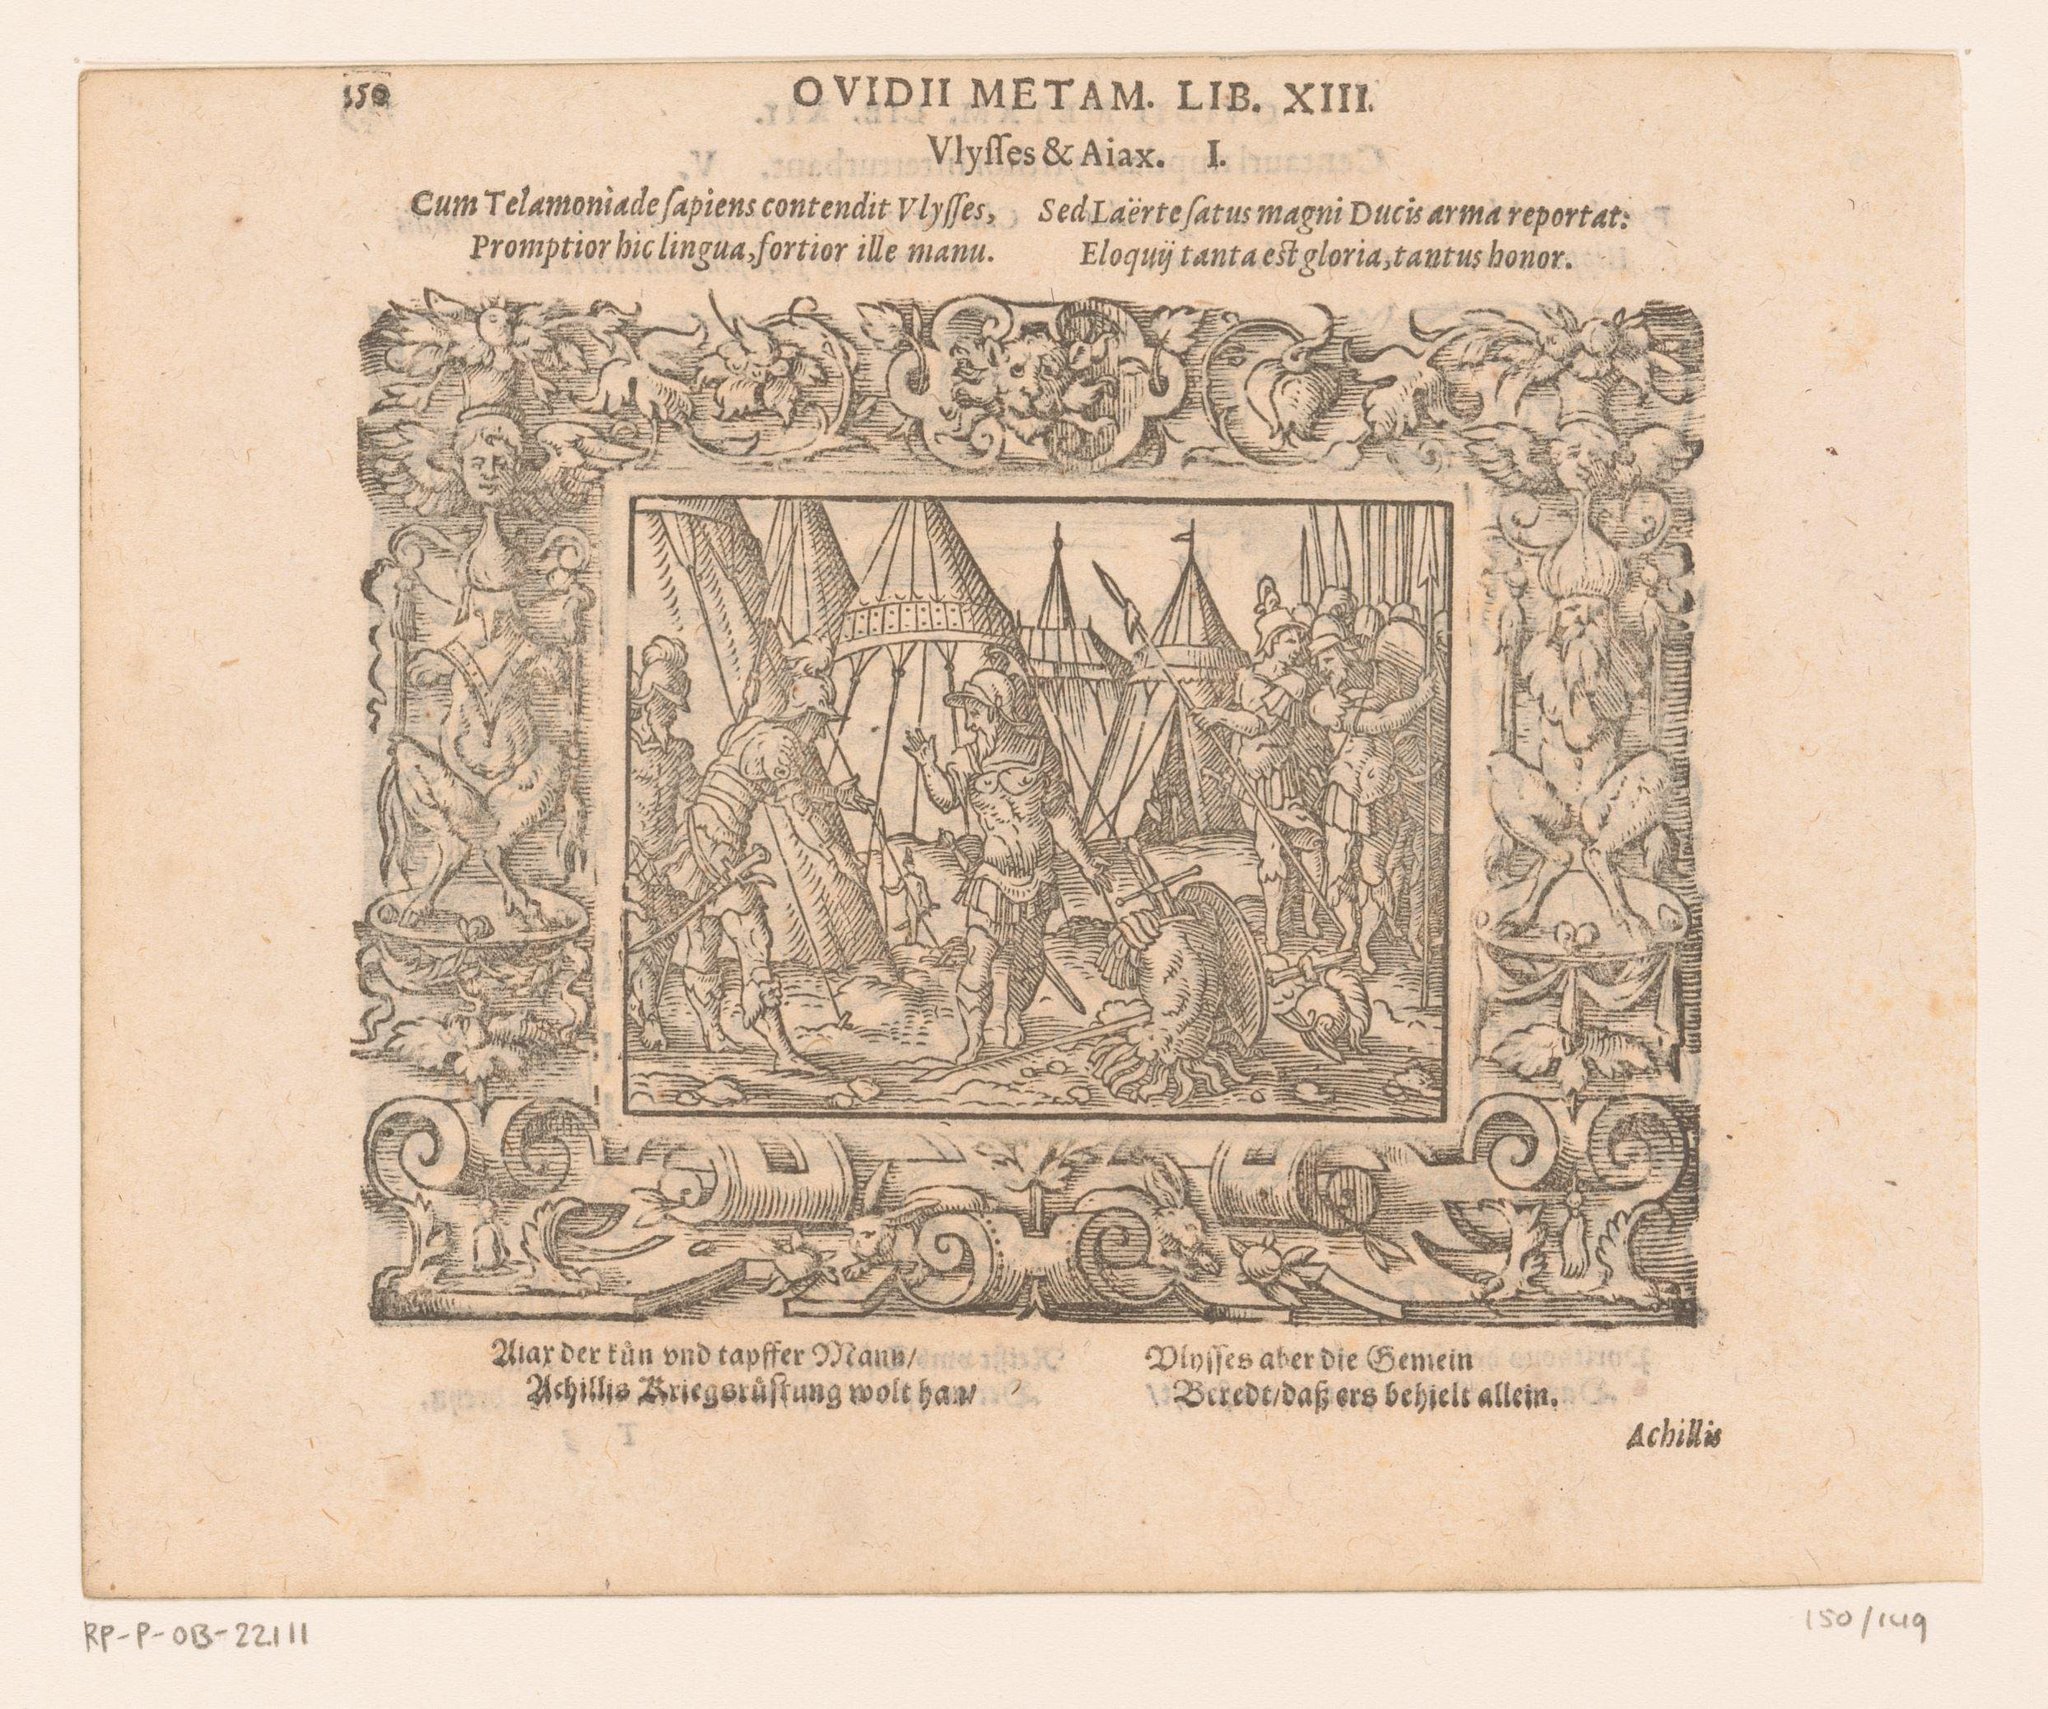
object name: book illustration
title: Ajax en Odysseus twisten om de wapens van Achilles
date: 1569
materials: paper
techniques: letterpress printing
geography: frankfurt am main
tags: fight between ulysses and ajax the great for achilles' arms, scrollwork, strapwork ~ ornament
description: Illustratie bij de Metamorfosen van Ovidius, afkomstig uit de publicatie: Posthius, Johannes. Tetrasticha in Ovidii metam. Frankfurt am Main: Georg Rab en Sigmund Feyerabend en erven Weigand Han, 1569. De voorstellingen en ornamentranden van deze boekillustraties zijn van twee aparte blokken gedrukt. Beide werden afzonderlijk van elkaar ook gebruikt voor andere publicaties, en de ornamentranden werden eveneens binnen deze publicatie meerdere keren gebruikt.